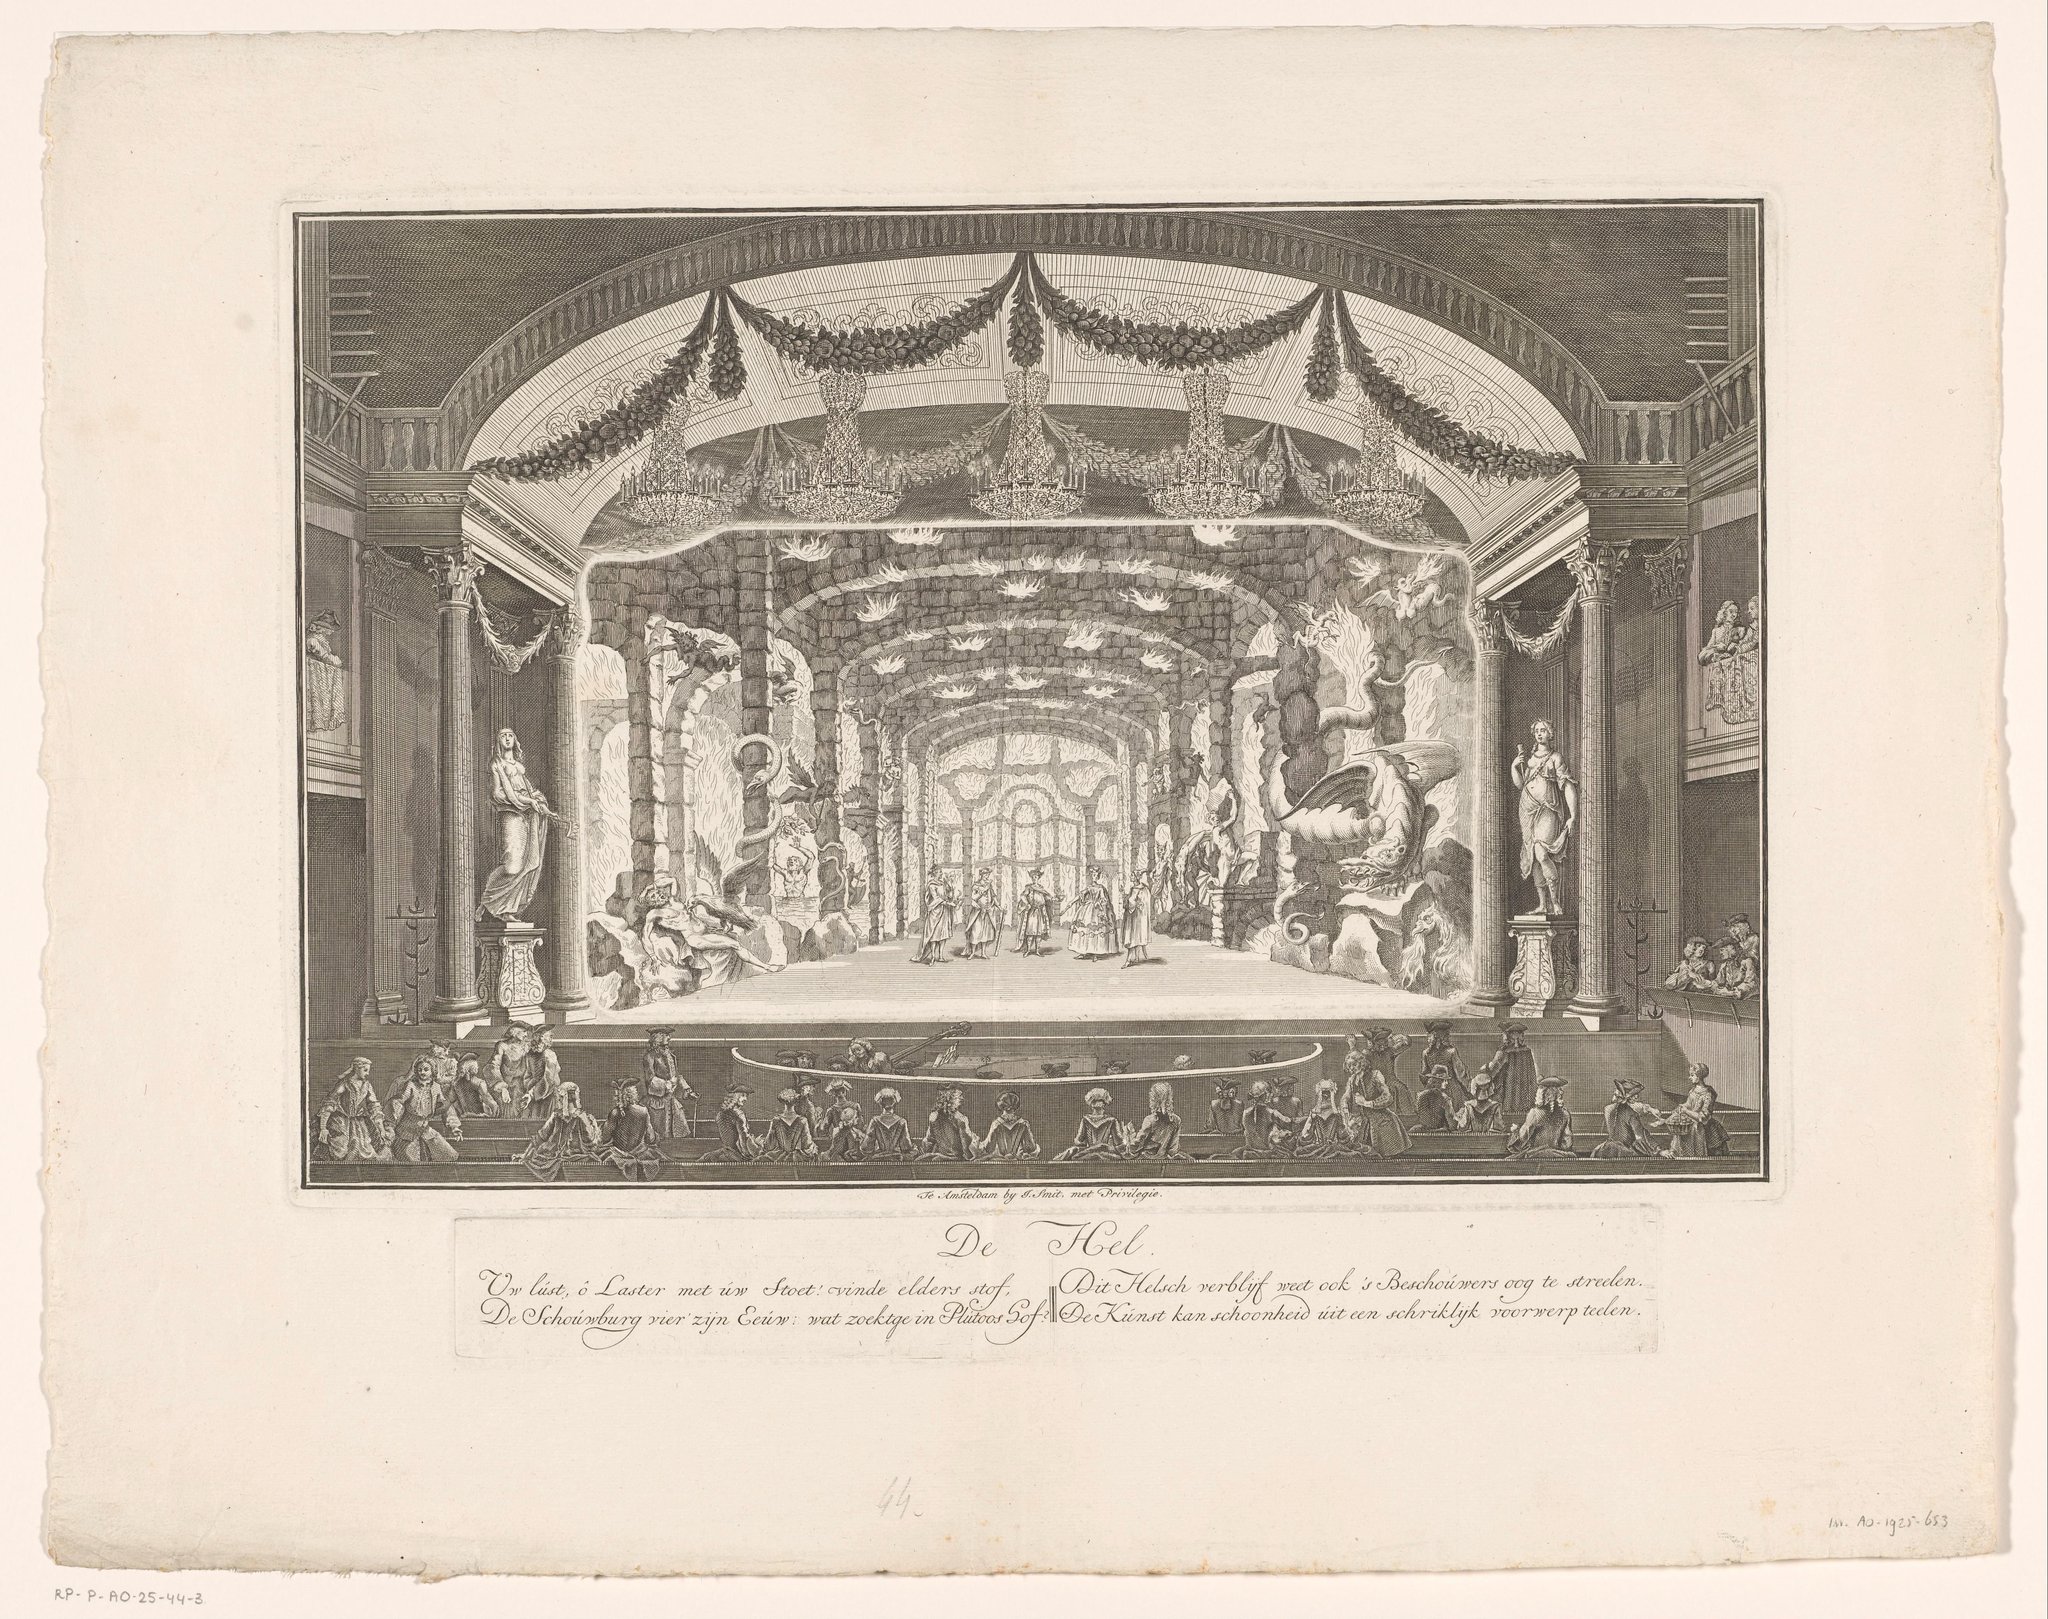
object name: print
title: Schouwburg met toneeldecor: De Hel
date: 1738-1740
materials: paper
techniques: engraving, etching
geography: amsterdam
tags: theatre, theatrical performance, stage design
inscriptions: collector's mark: Lugt 2228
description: Toneelvoorstelling in de Amsterdamse Schouwburg op de Keizersgracht met het coulissendecor De Hel met scène uit: Het Eeuwgetijde van den Amsteldamschen Schouwburg. Het decor gedrukt van een aparte plaat binnen een passe-partout met de zaal, zijloges, orkestbak en de façade van het toneel met zuilen, guirlandes en kroonluchters. De titel en een vierregelig vers ook gedrukt van een aparte plaat. Onderdeel van een serie van 12 toneeldecors.